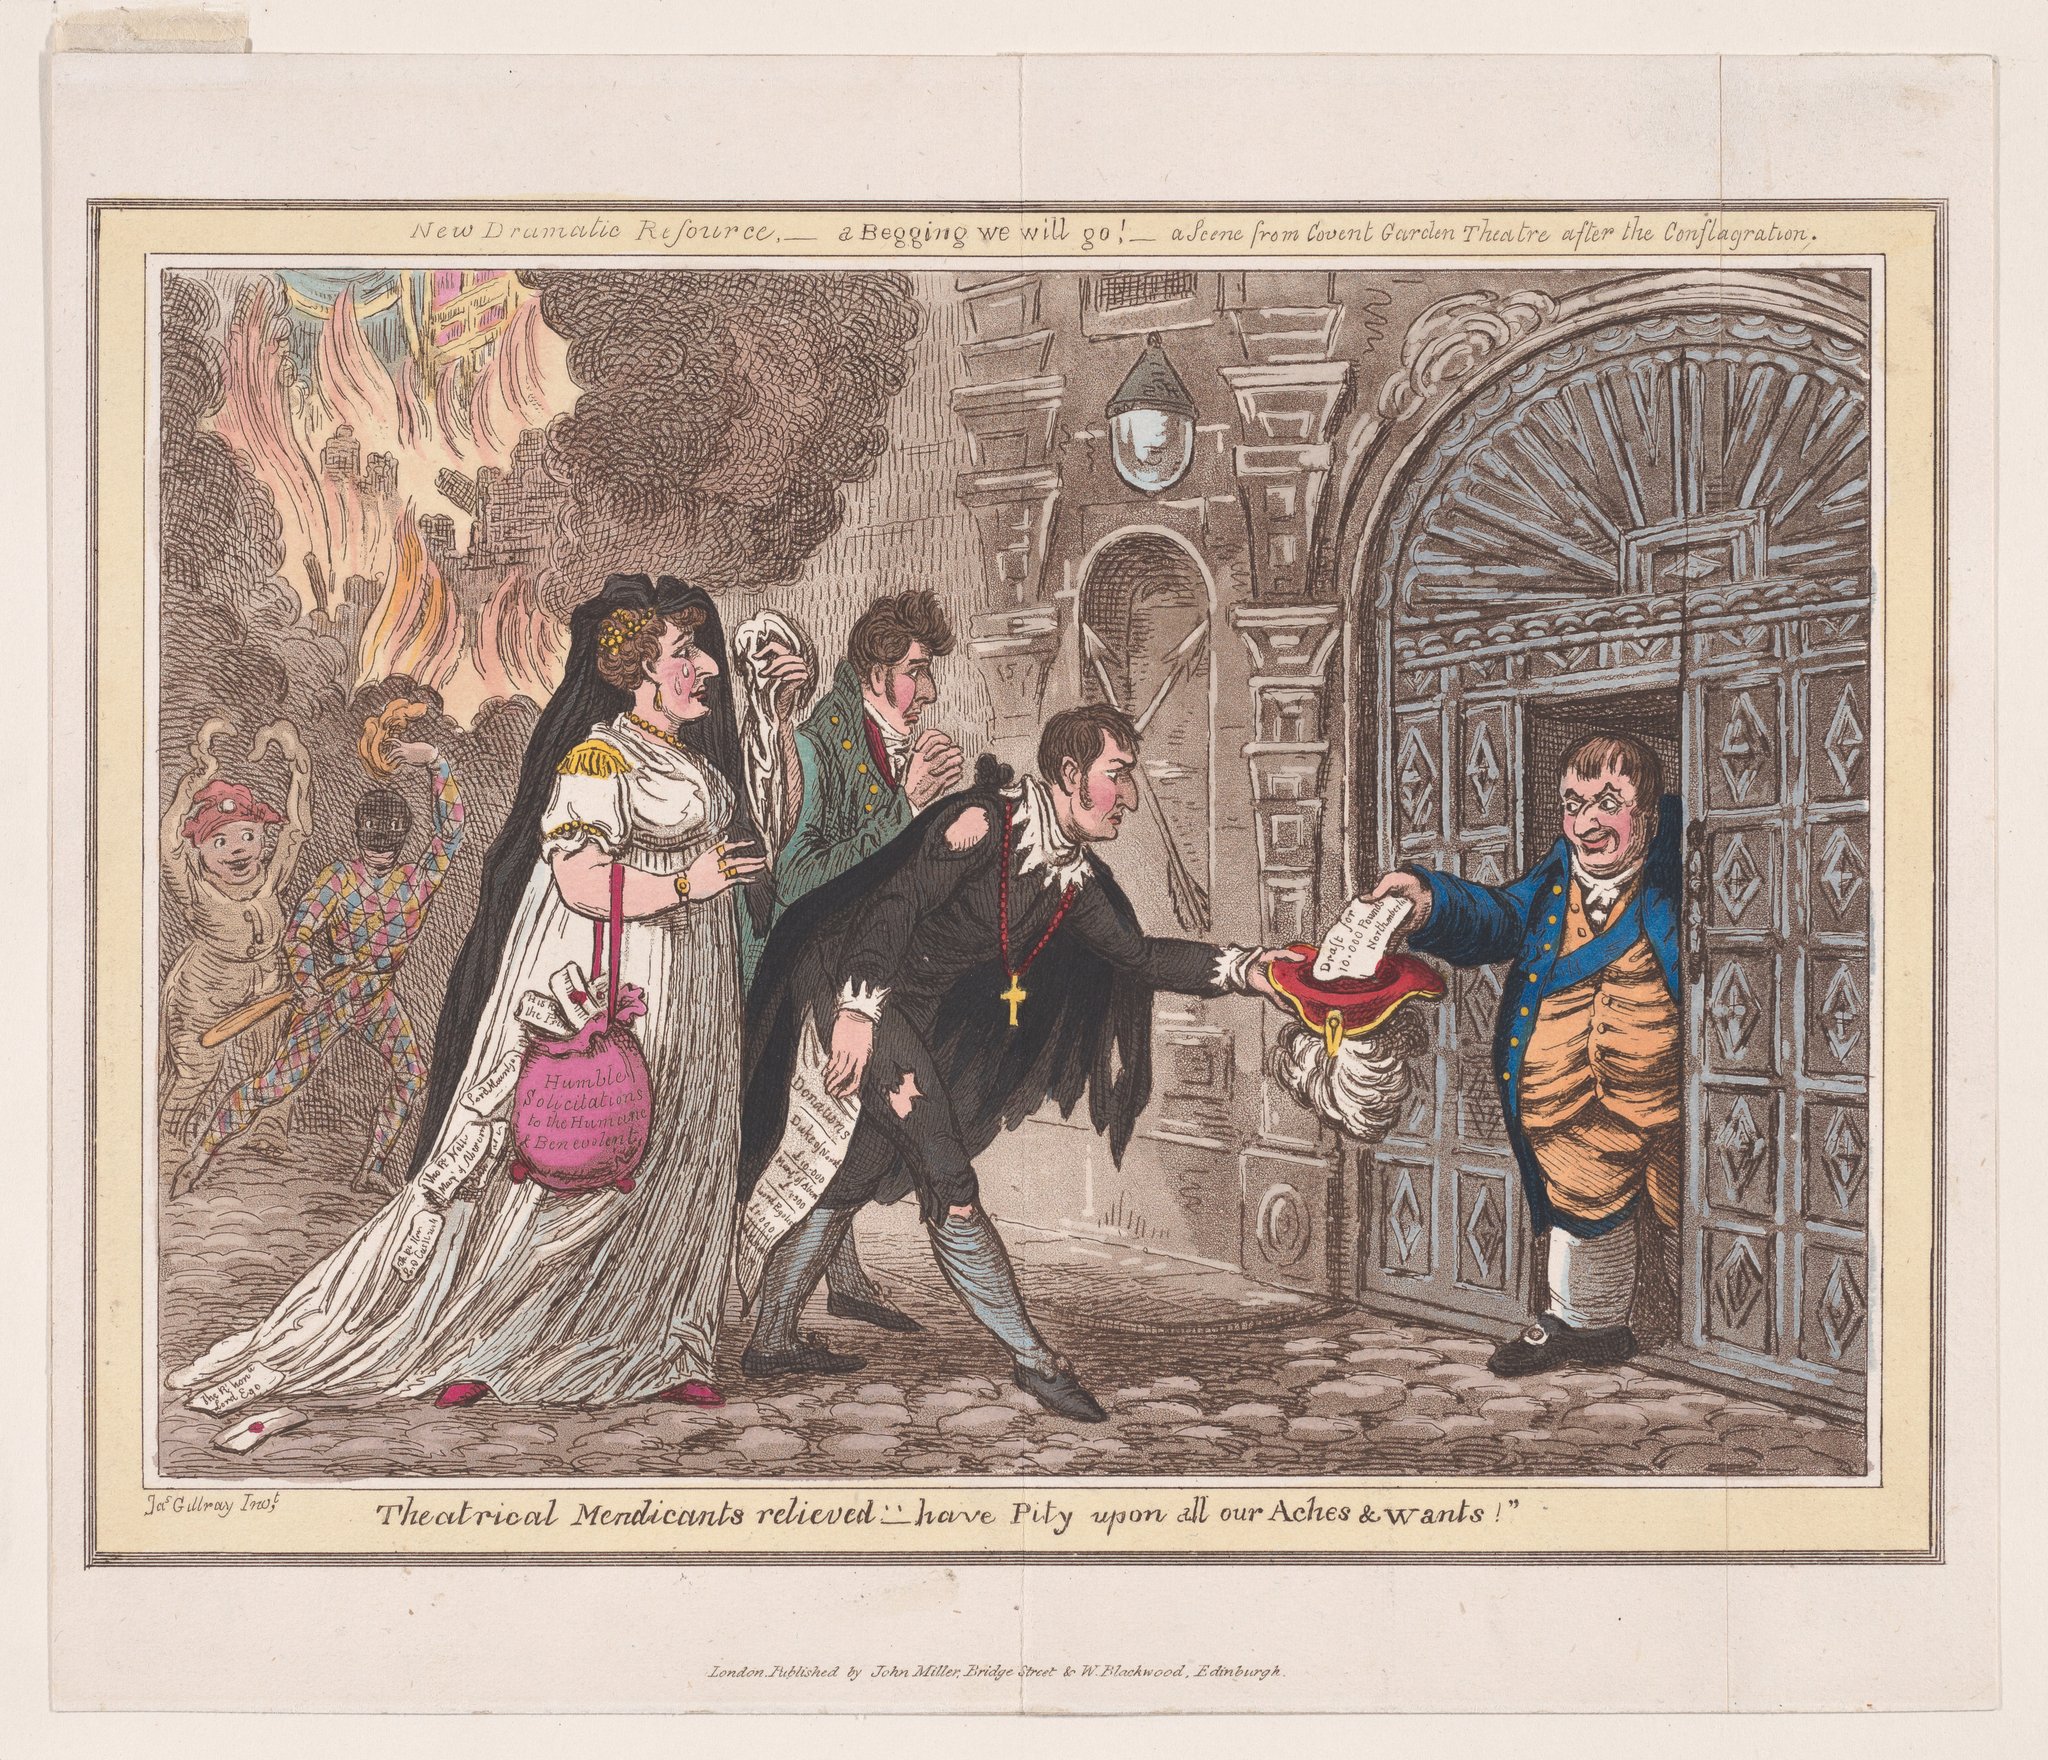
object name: print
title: Theatrical Mendicants Relieved - have Pity upon all our Aches and Wants!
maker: james gillray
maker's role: artist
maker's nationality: british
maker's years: 1756-1815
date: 1824-1827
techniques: etching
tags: satire,theatre,men,women,fire,caricature